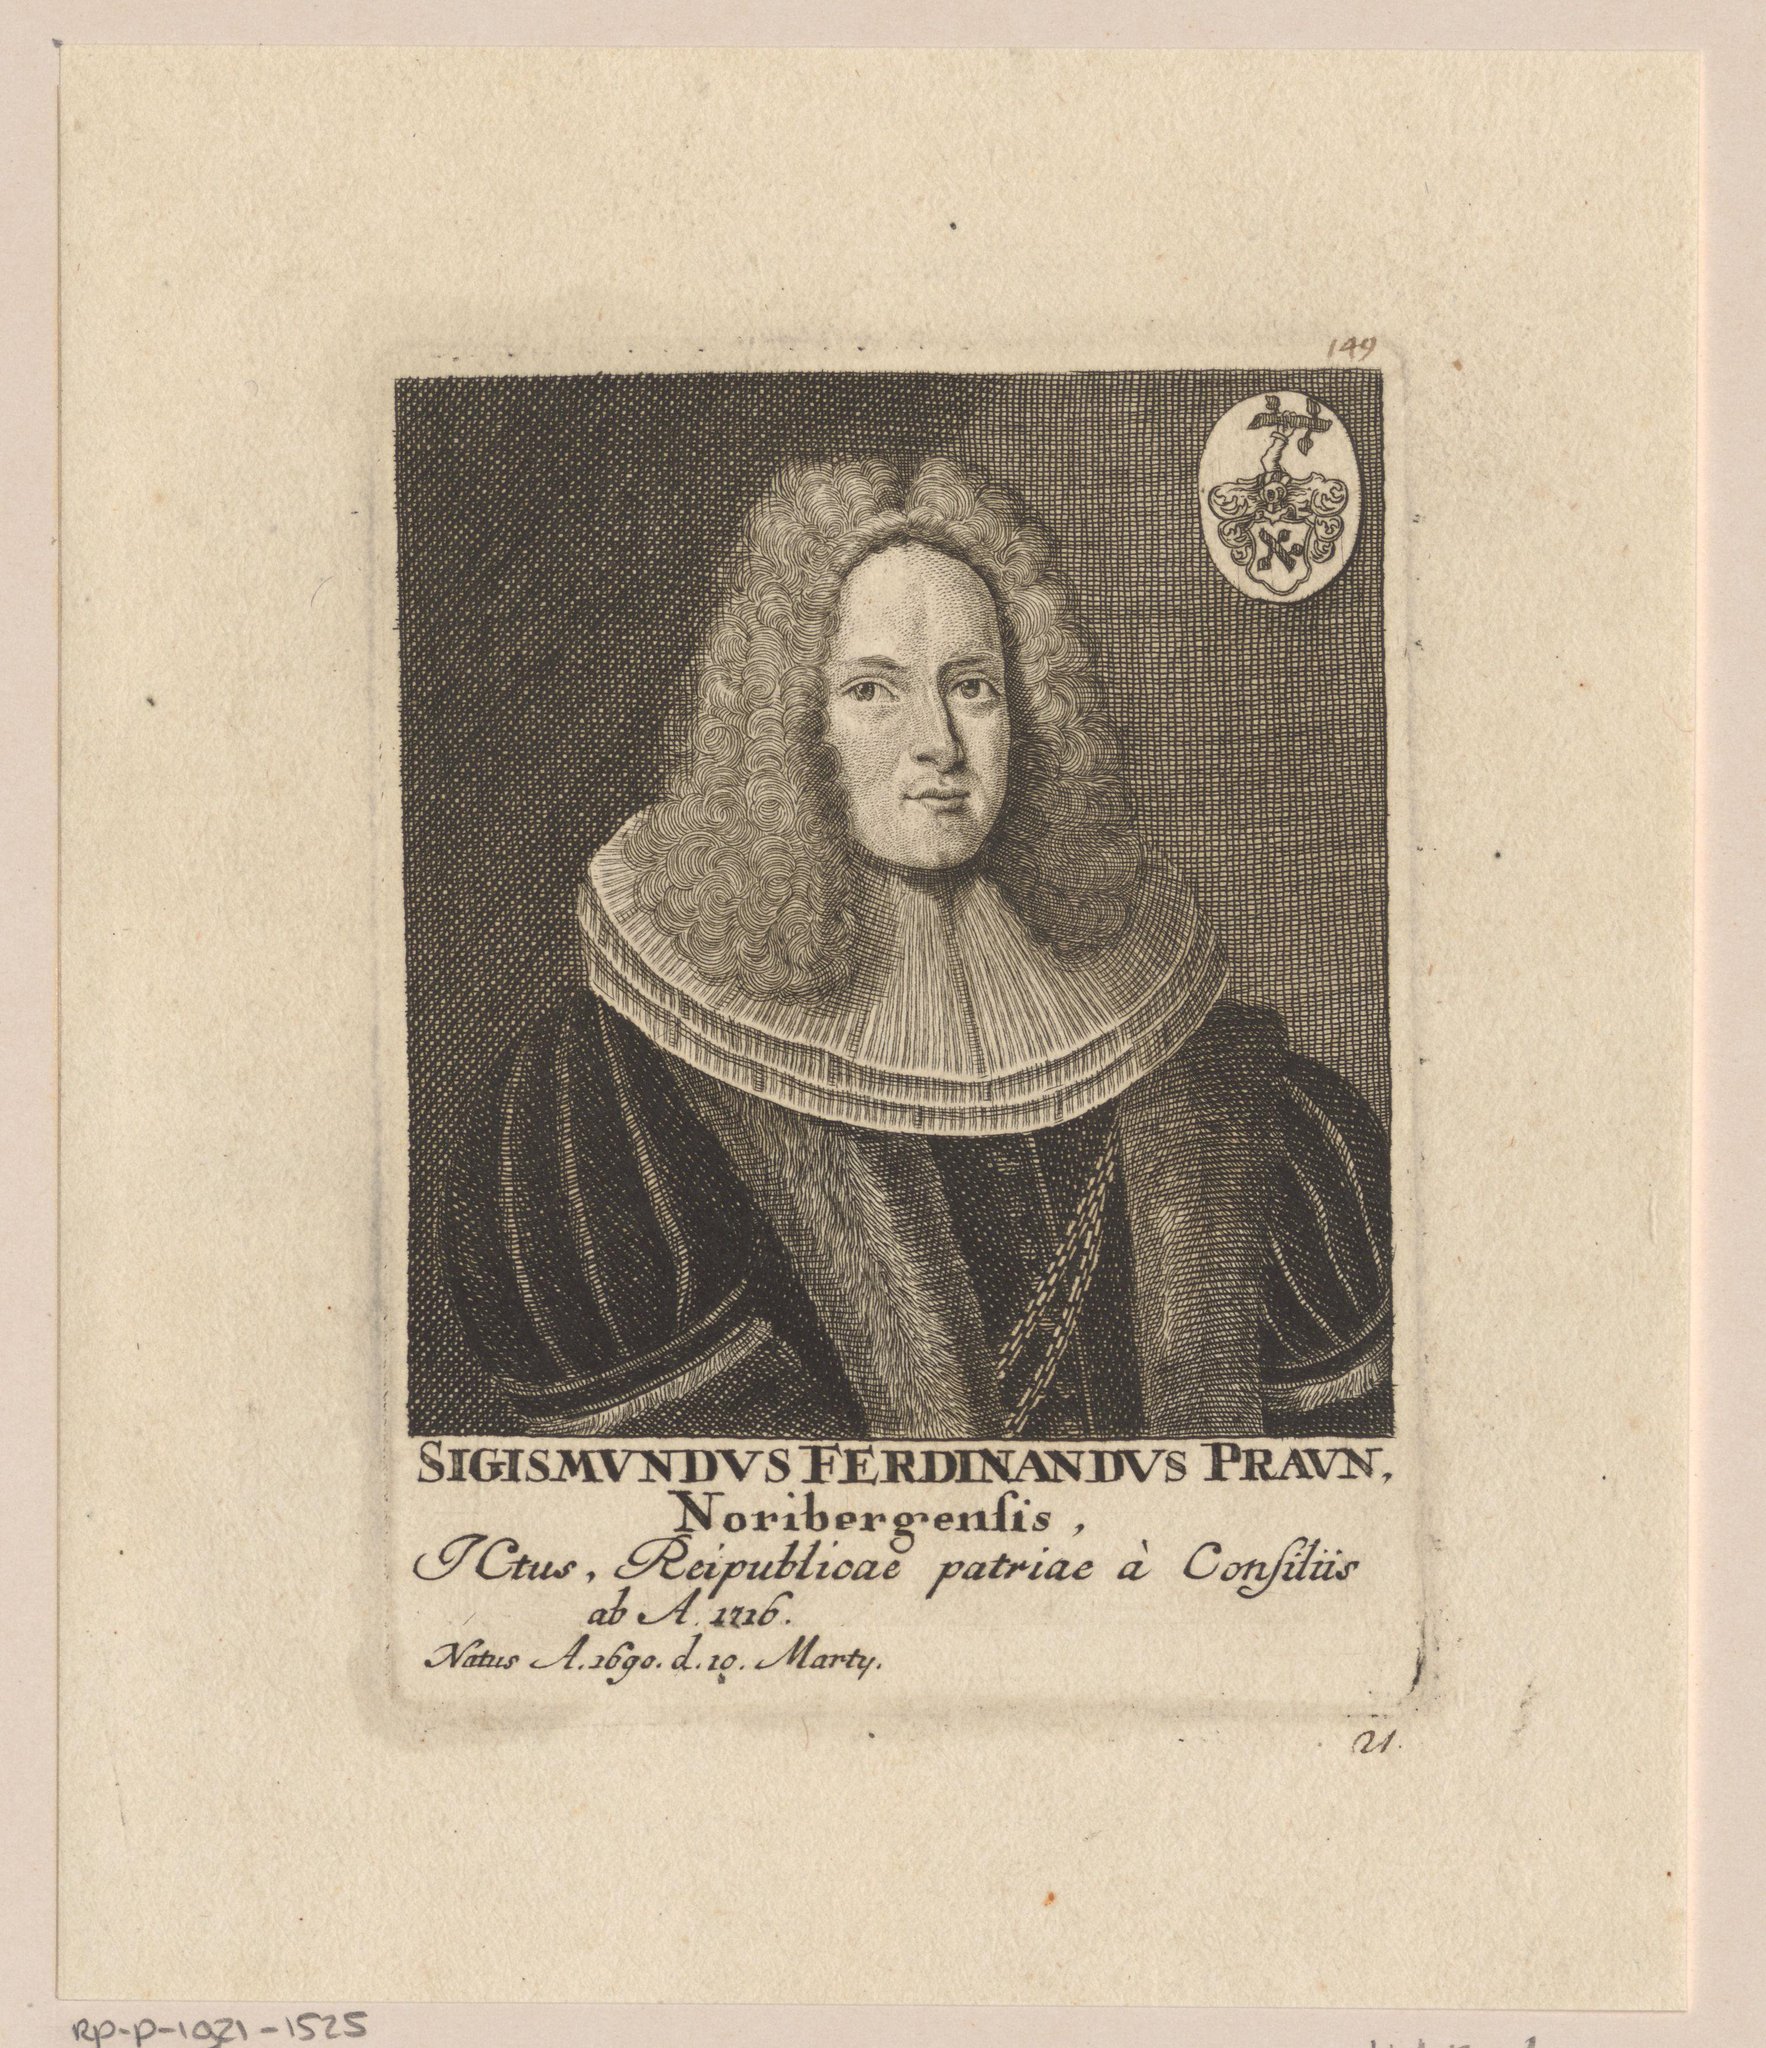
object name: print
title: Portret van Sigmund Ferdinand Praun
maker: Anonymous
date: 1725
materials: paper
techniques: engraving, etching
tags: city council, historical persons, armorial bearing, heraldry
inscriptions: collector's mark: Lugt 2233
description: Prent uit: Rothscholtz, Friedrich. Icones virorum omnium ordinum eruditione: omnique item genere et varietate artium de republica litteraria et speciatim de Academiis et Gymnasiis (...). Neurenberg: erven Johann Daniel Tauber, 1725, dl. 1 of 2.